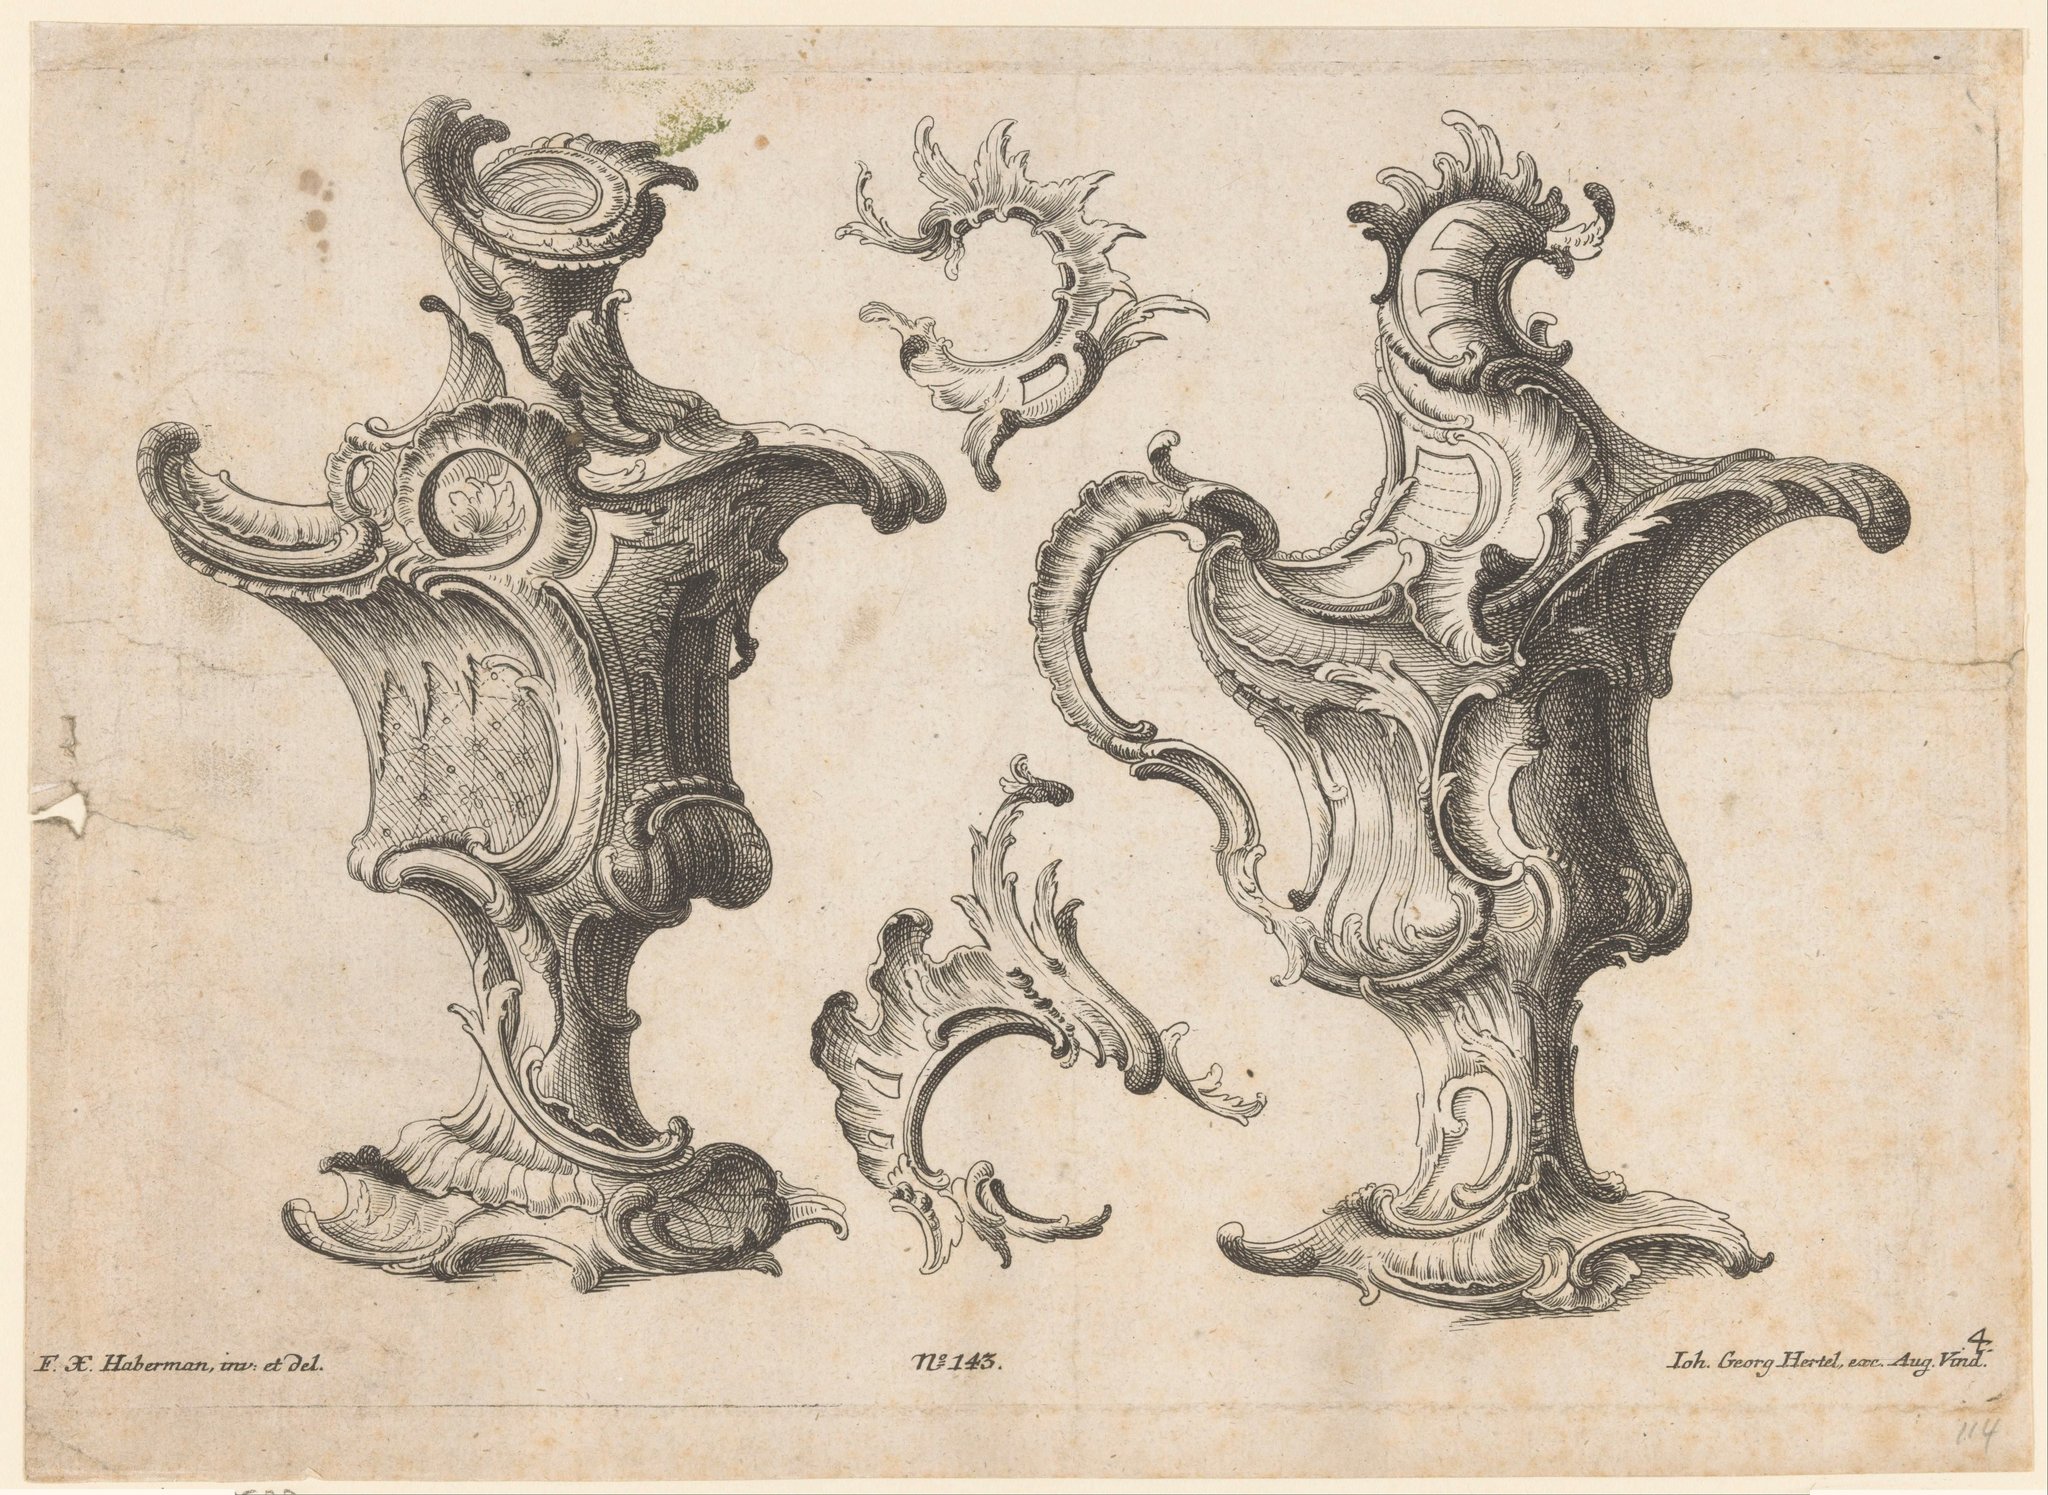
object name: ornament print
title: Kan en vaas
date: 1731-1775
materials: paper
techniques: etching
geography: augsburg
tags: rocaille ornament, vase ~ ornament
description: Een kan en een vaas met rocaille ornamenten. Uitgeversnummer 143.